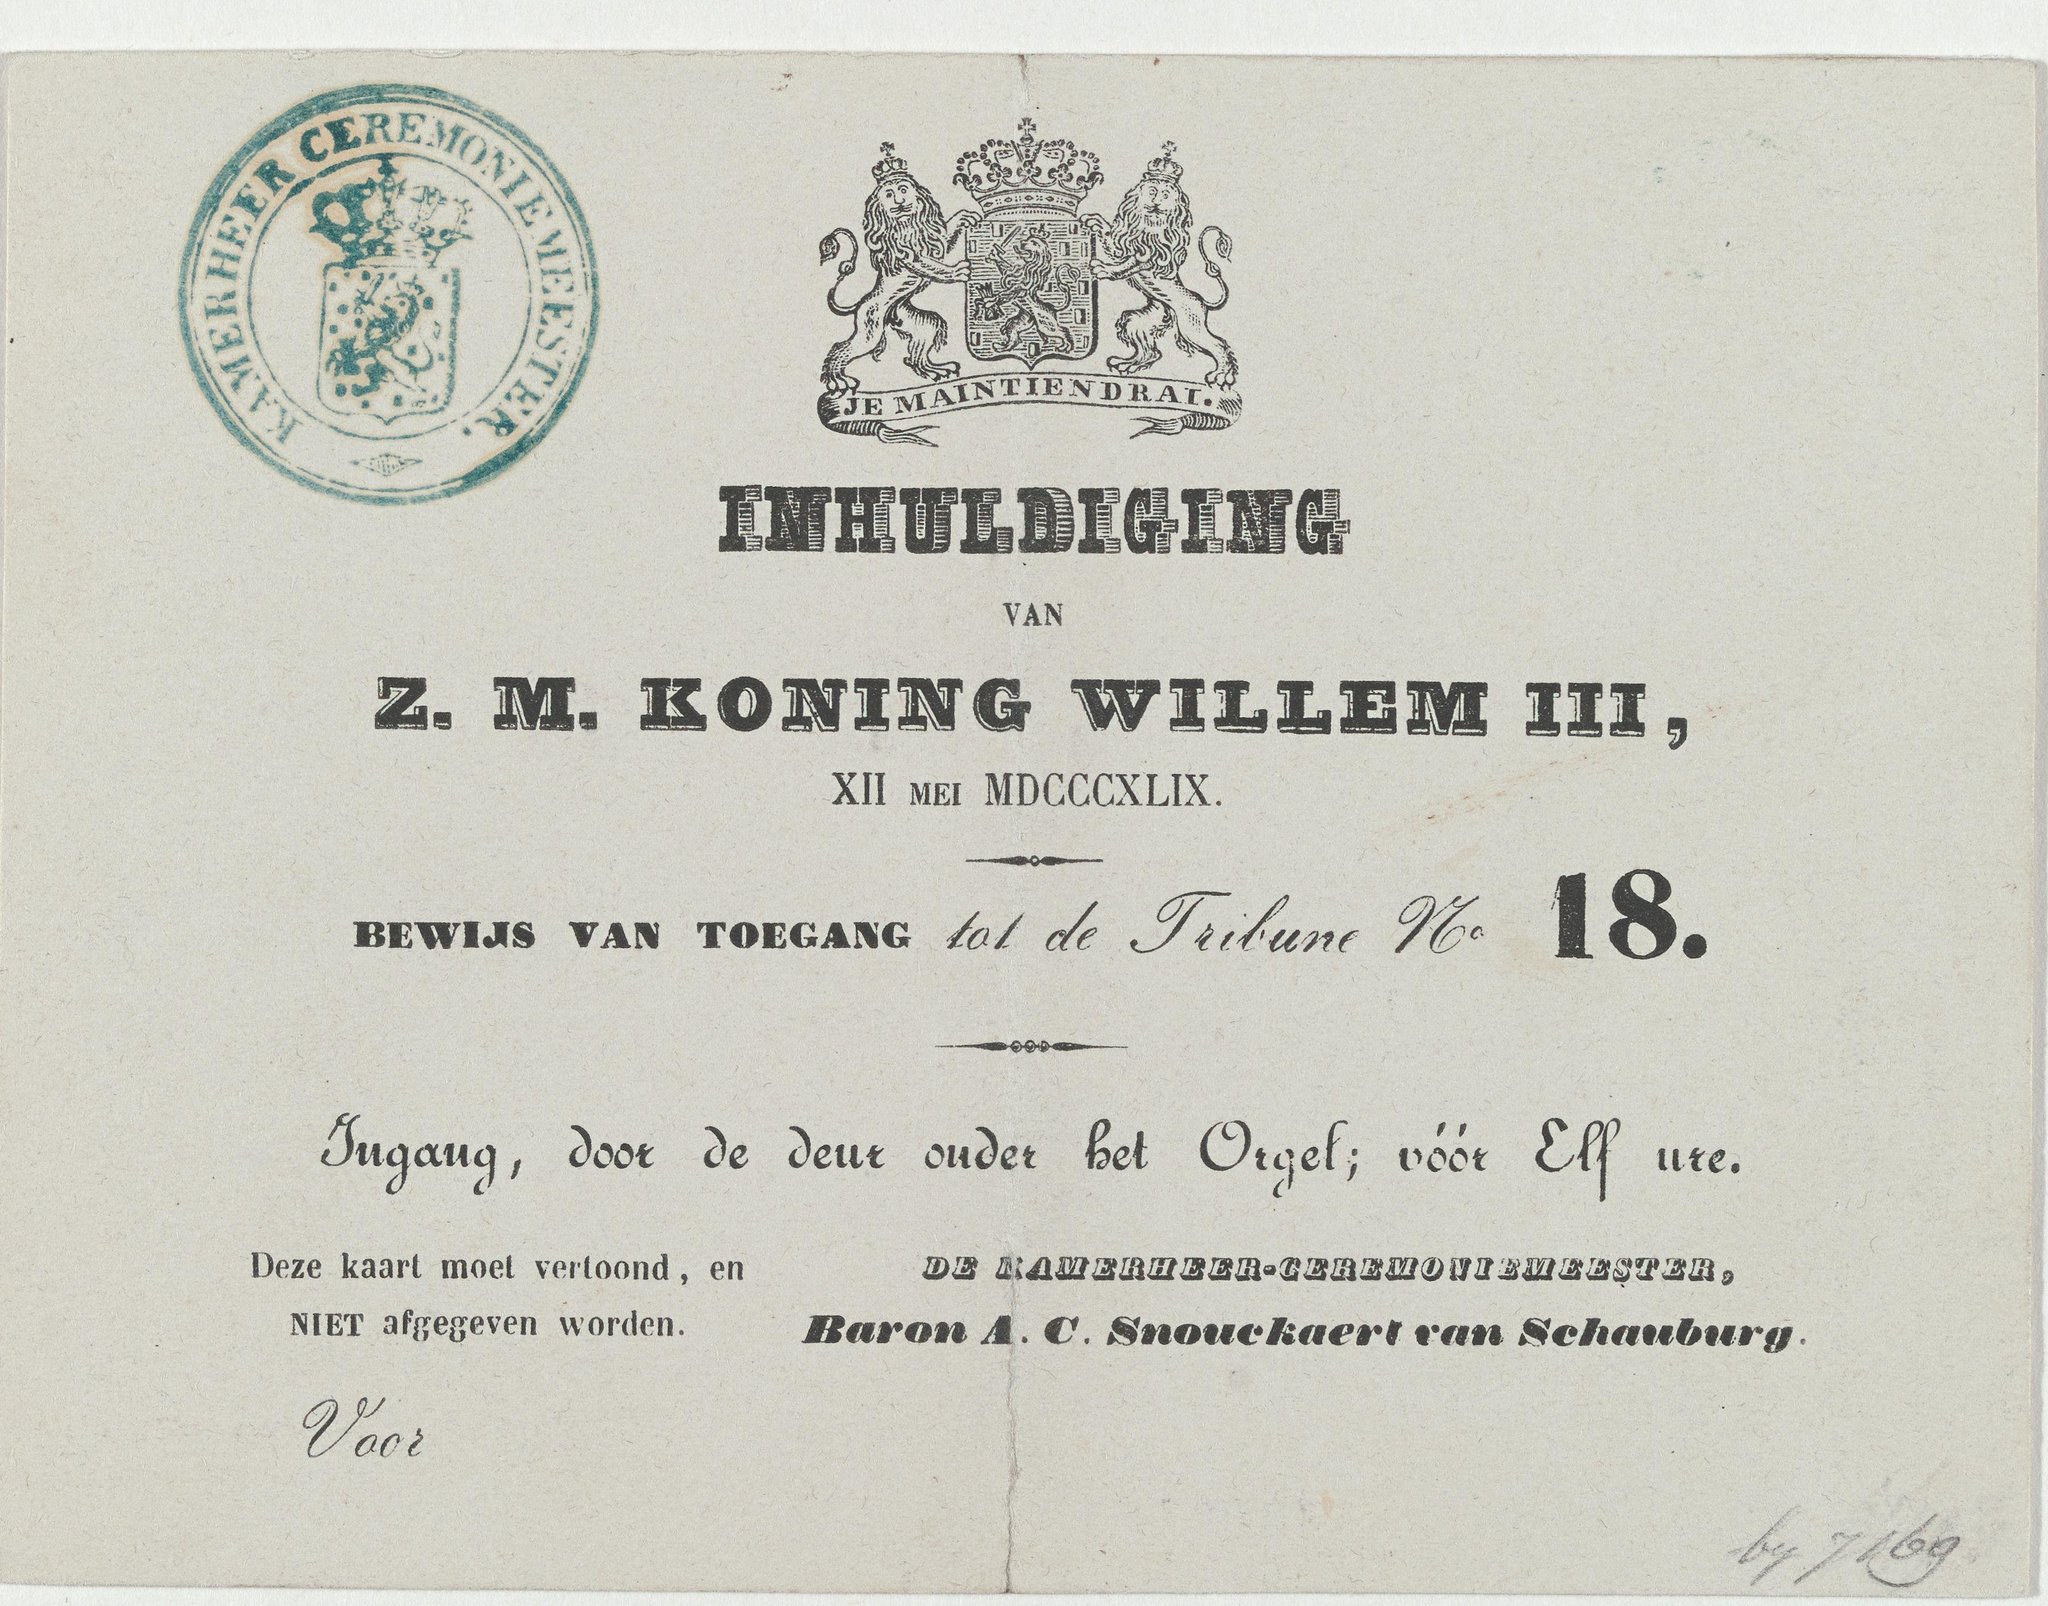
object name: admission ticket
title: Toegangsbewijs voor de inhuldiging van koning Willem III, 1849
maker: Anonymous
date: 1805-1849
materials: paper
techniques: letterpress printing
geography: netherlands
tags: willem iii (koning der nederlanden), installation of a ruler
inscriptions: collector's mark: Lugt 2228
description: Toegangsbewijs voor de inhuldiging van koning Willem III in de Nieuwe Kerk te Amsterdam op 12 mei 1849. Bewijs van toegang tot de tribune no. 18. Met de stempel van de kamerheer ceremoniemeester. Zonder naam.